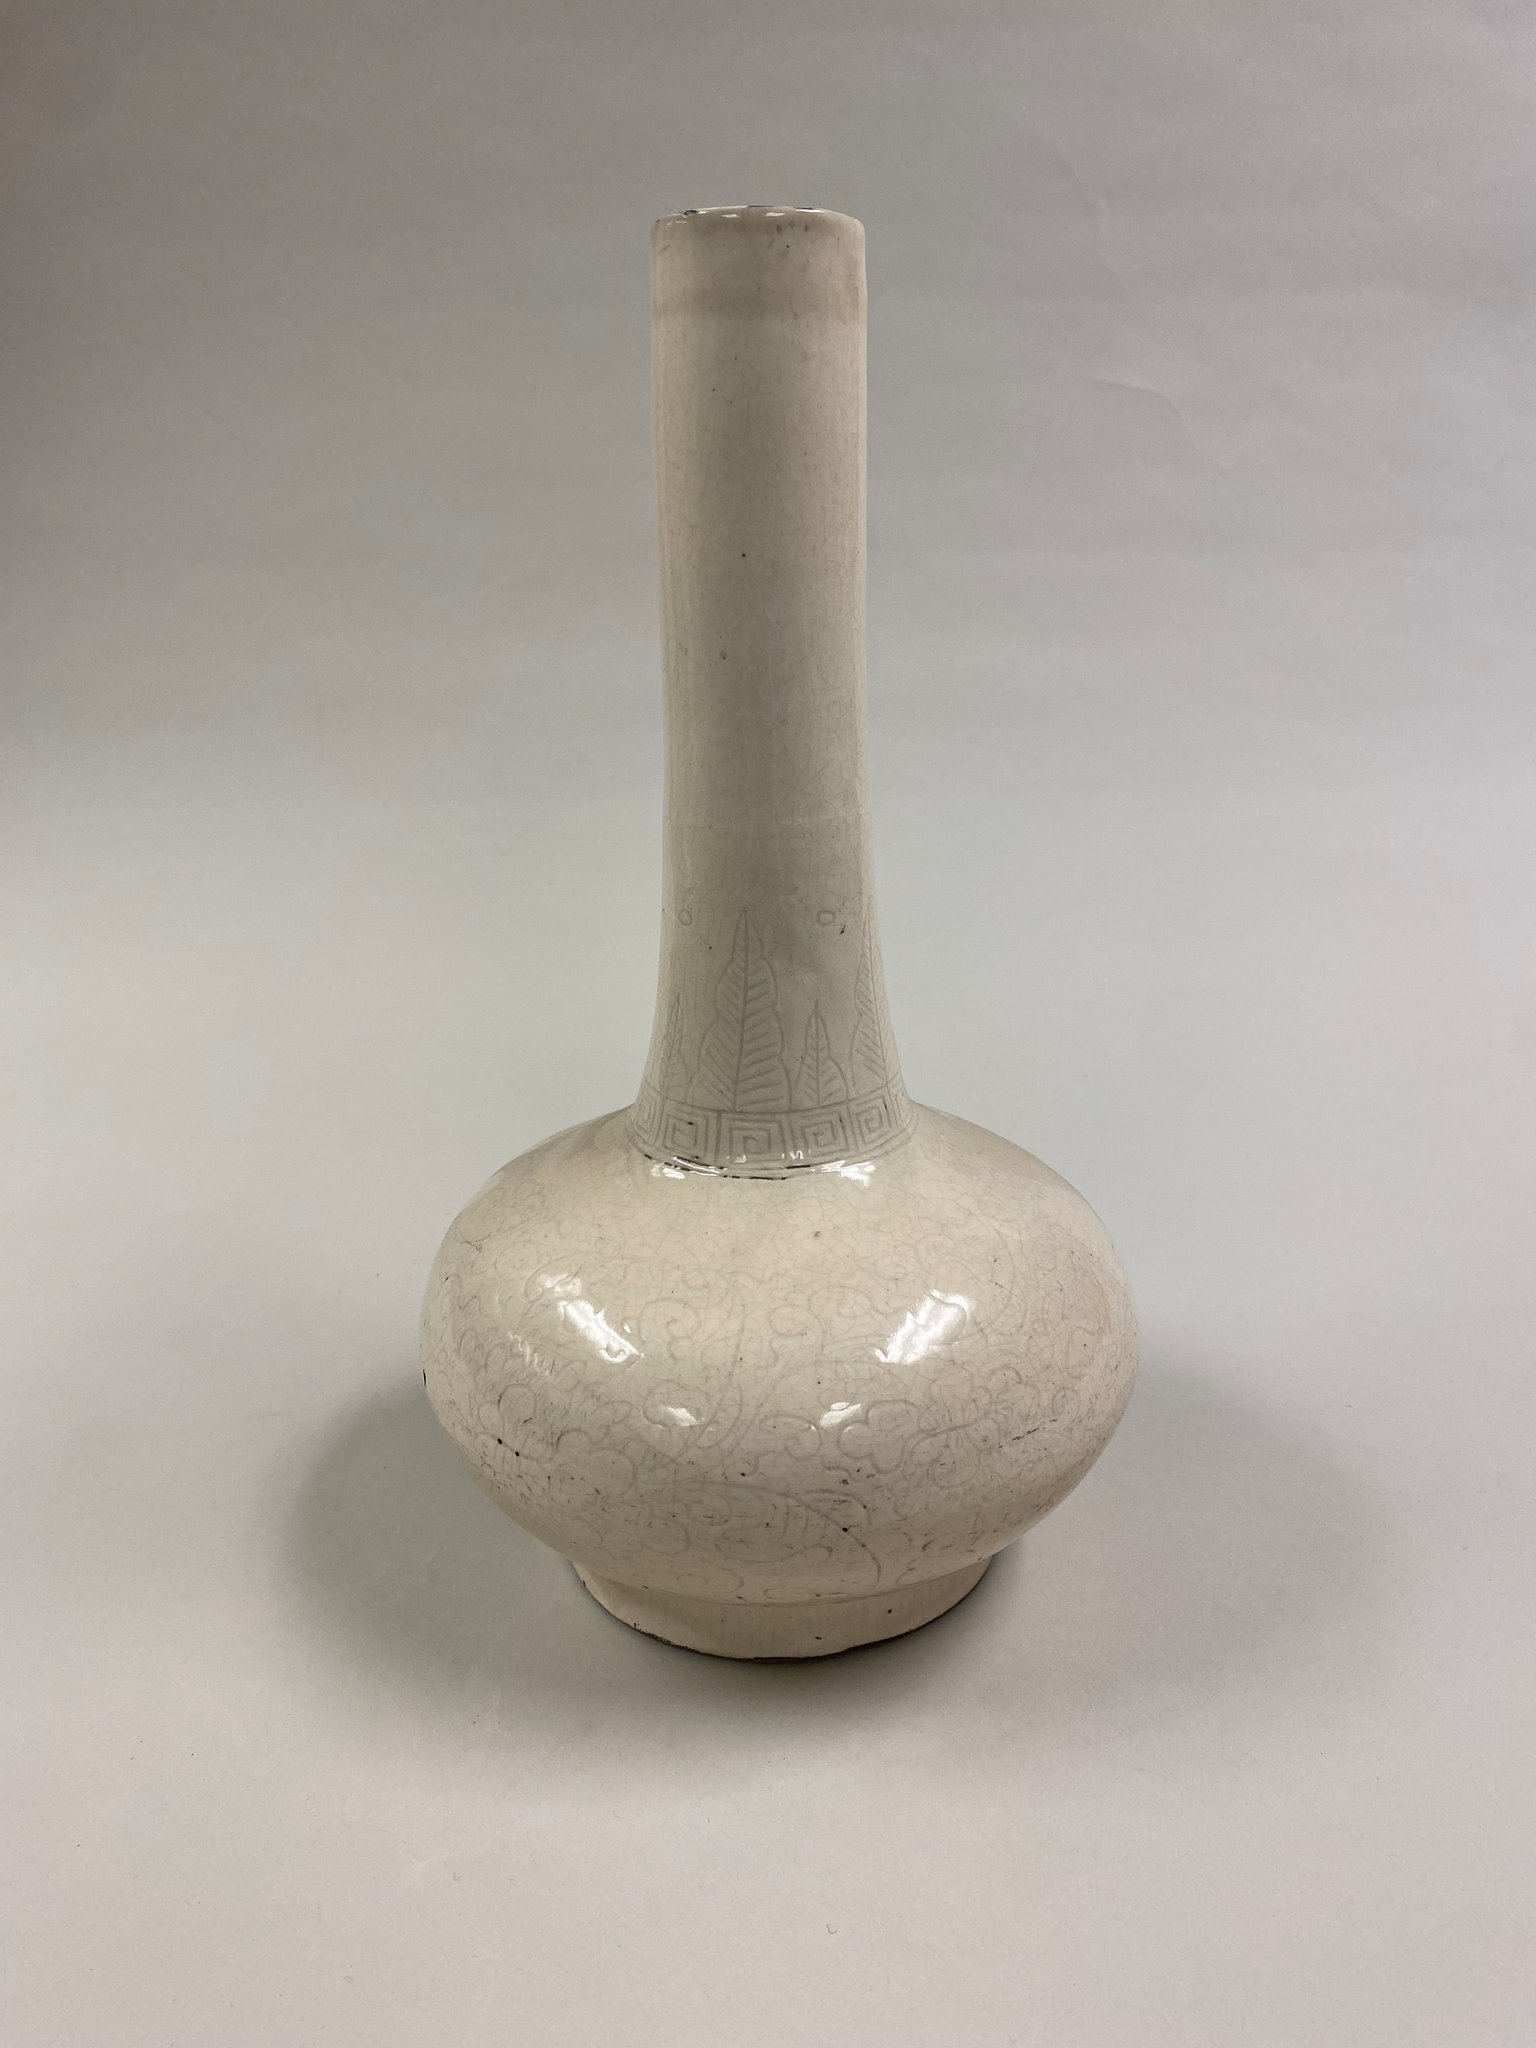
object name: bottle vase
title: Bottle vase with floral scrolls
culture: chinese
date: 1701-1800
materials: porcelain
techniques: incising